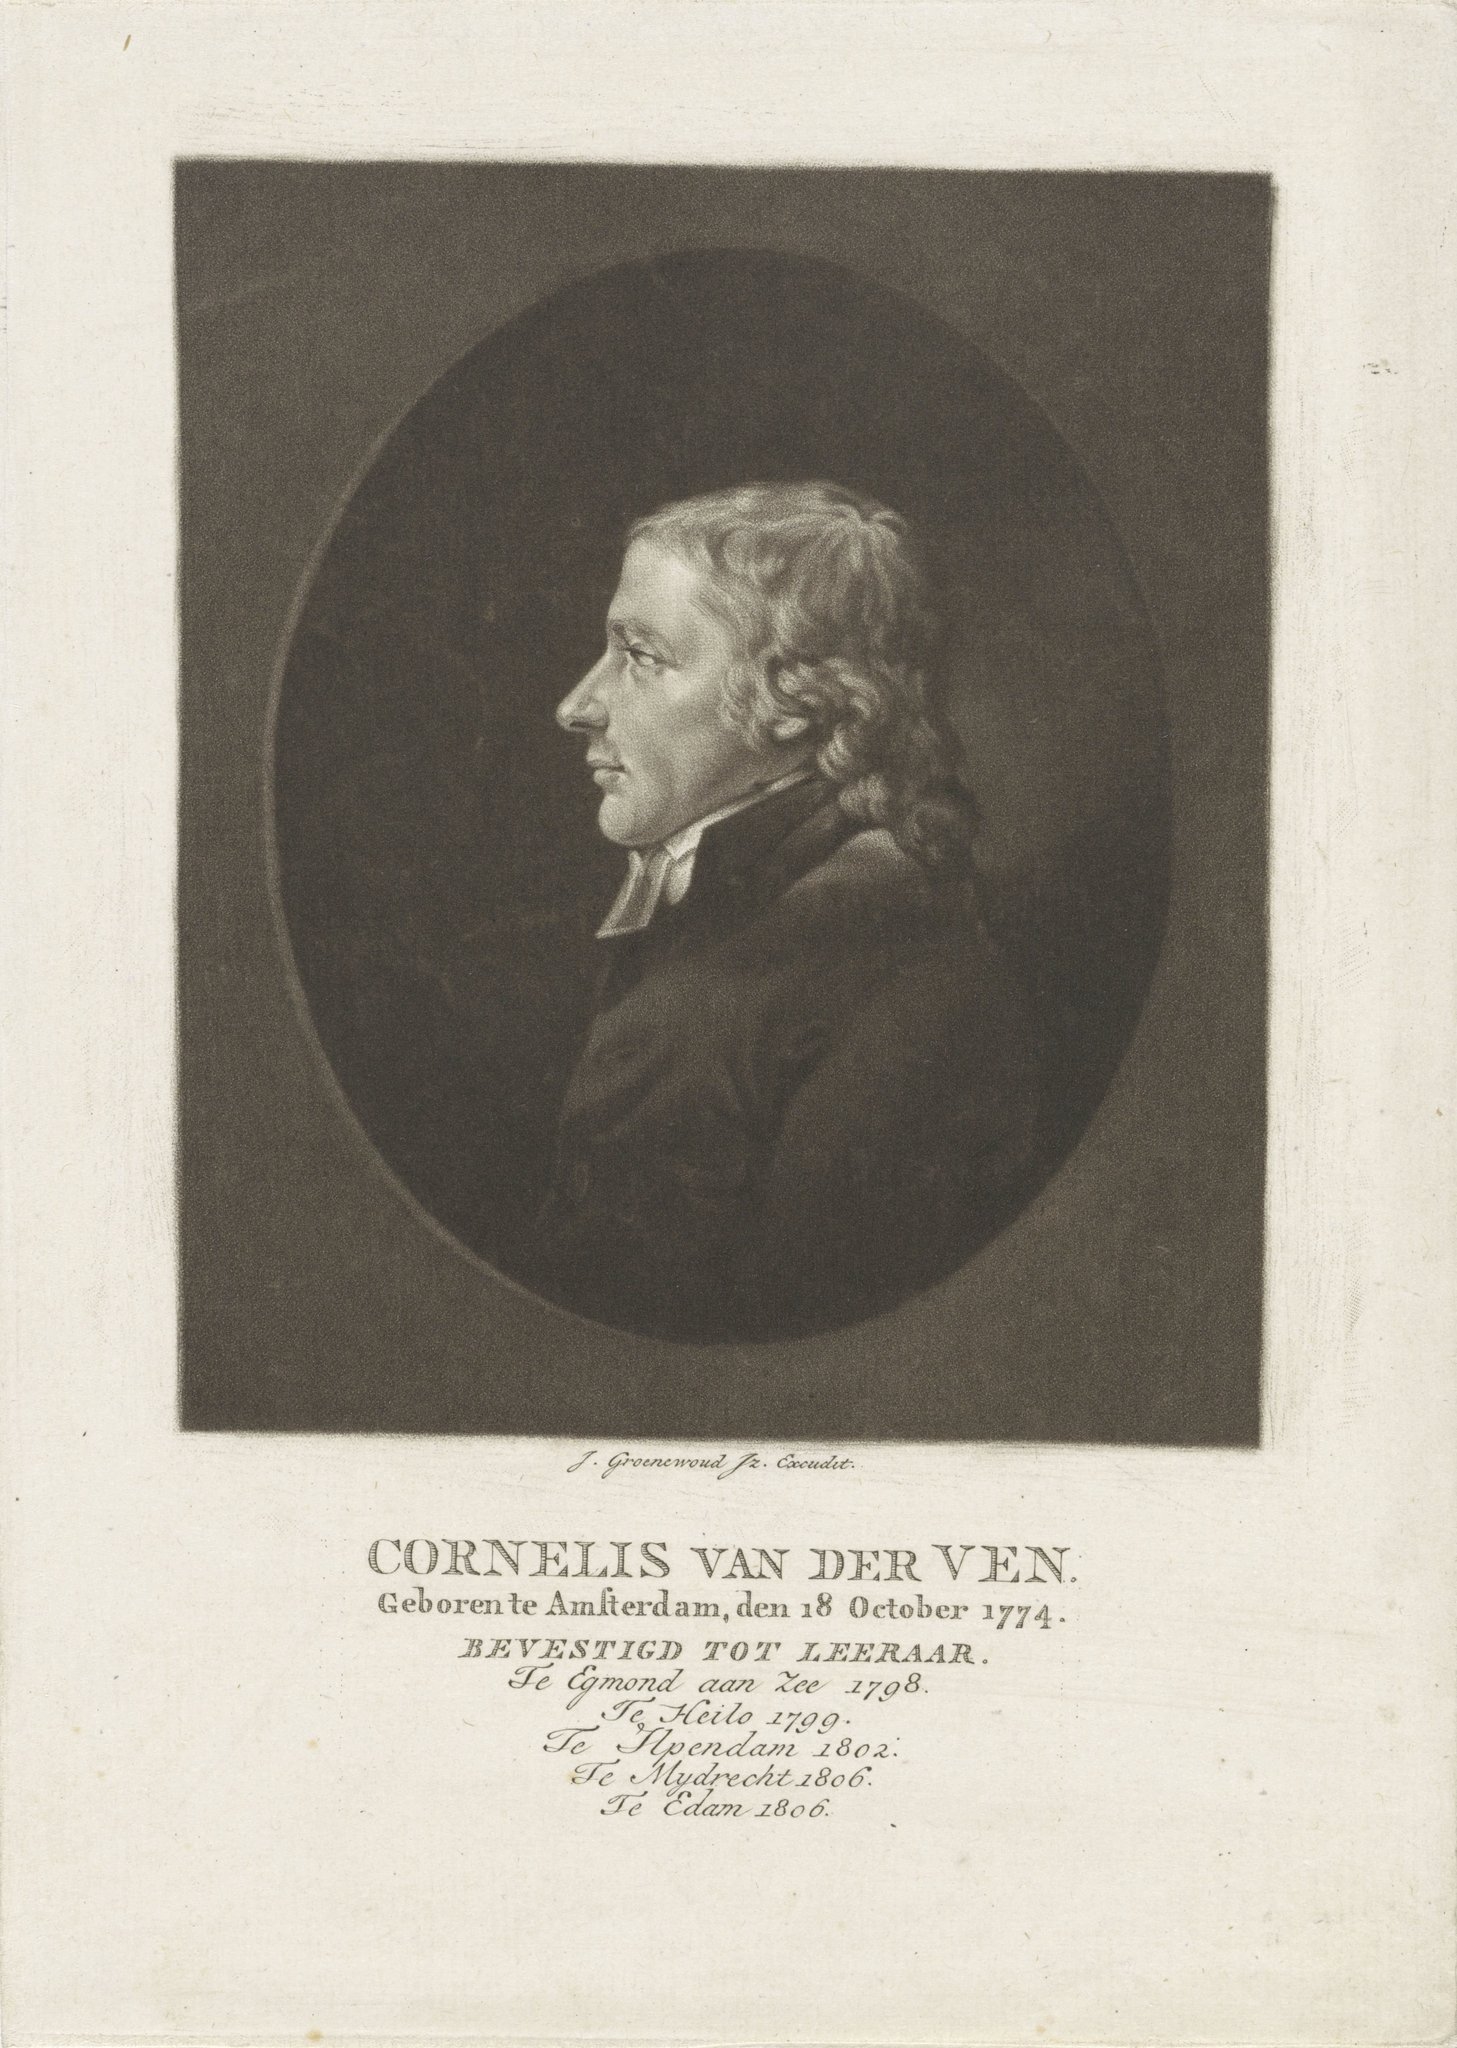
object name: print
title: Portret van de predikant Cornelis van der Ven, in profiel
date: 1804-1806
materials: paper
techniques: engraving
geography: amsterdam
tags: predikant, cornelis van der ven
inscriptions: collector's mark: Lugt 2228